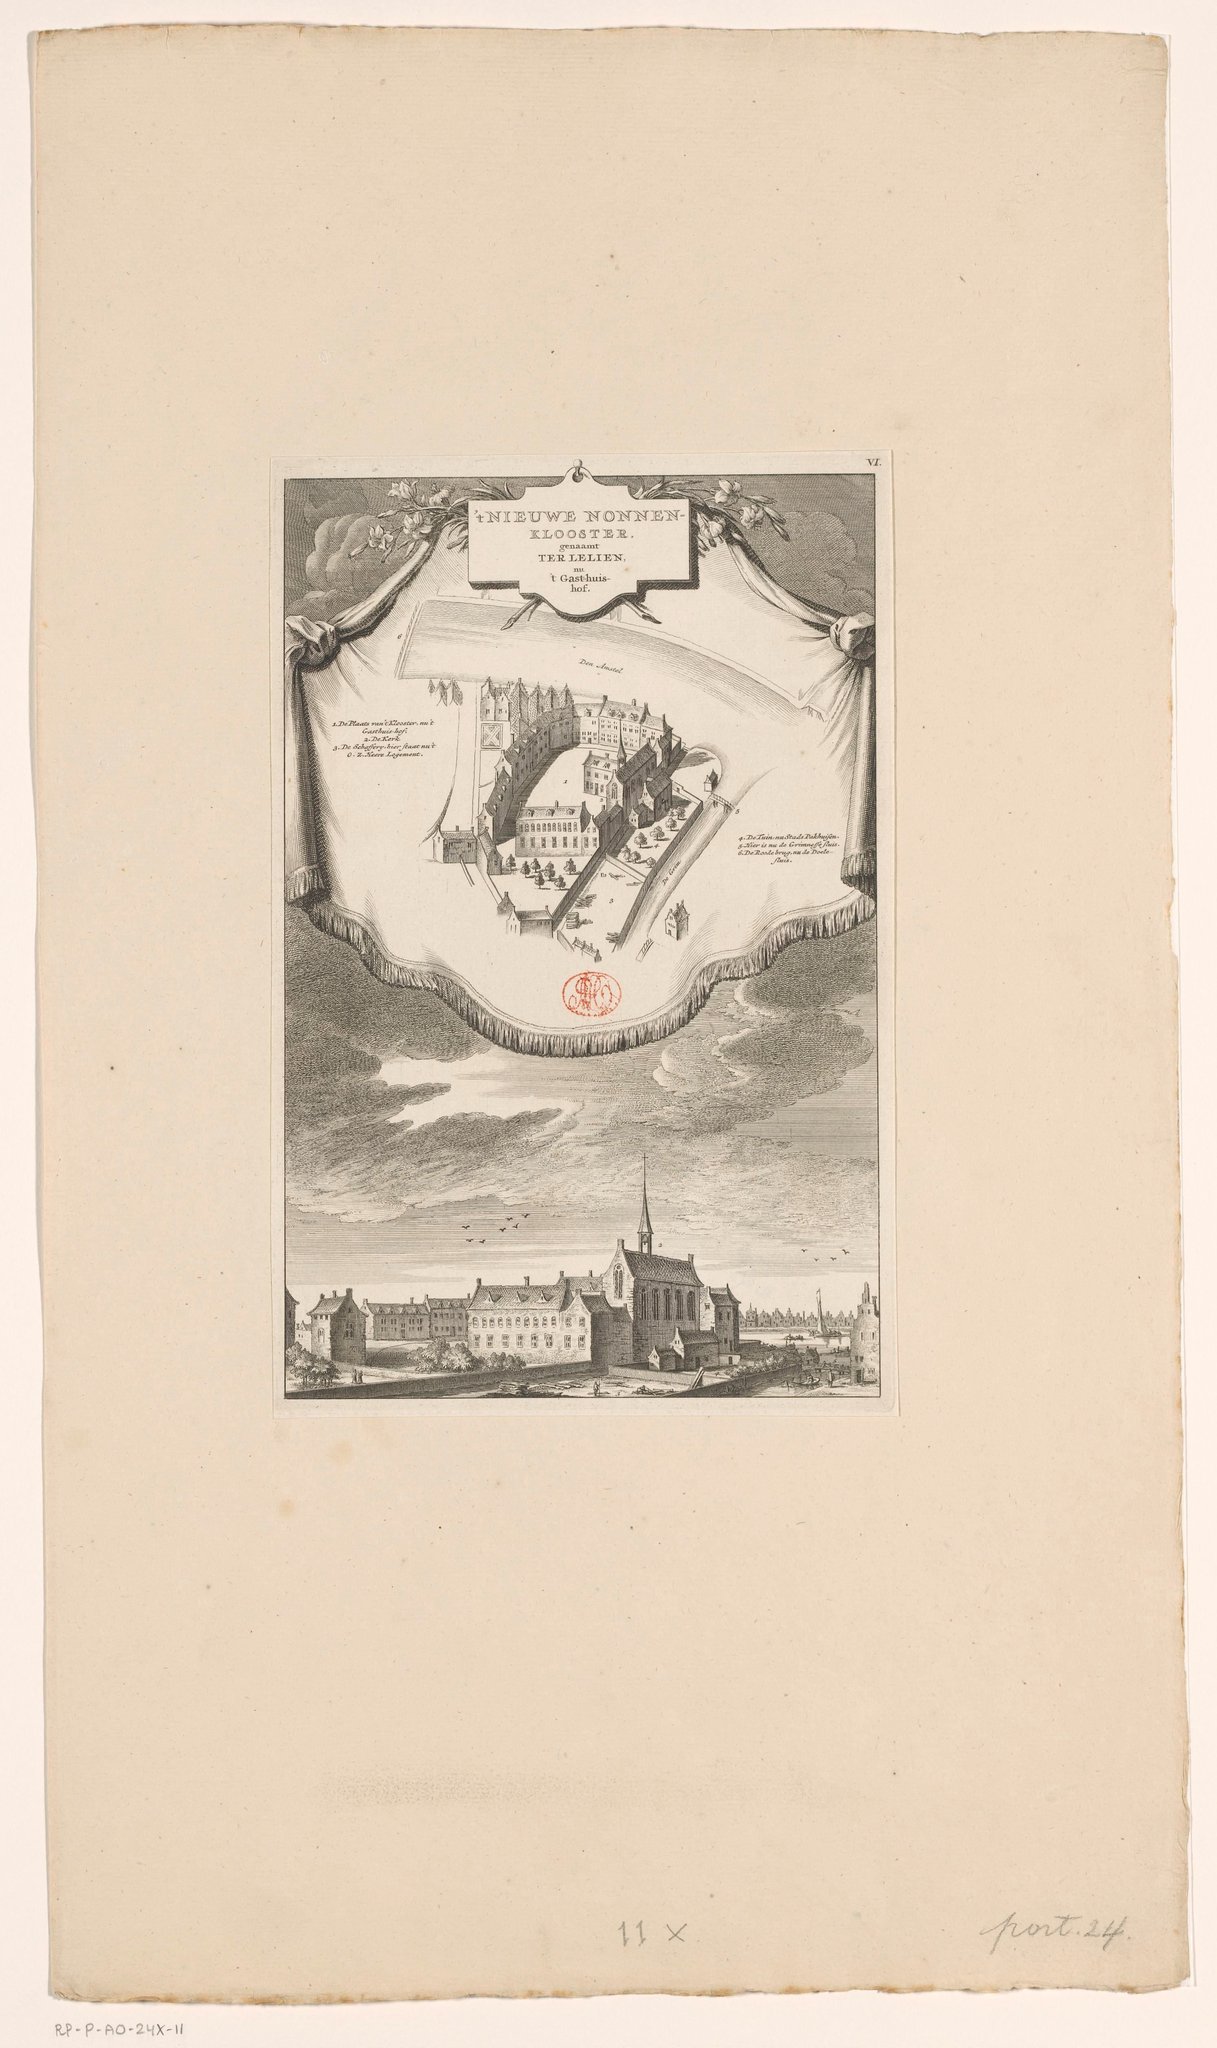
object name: print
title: Gezichten op het Nieuwe Nonnenklooster te Amsterdam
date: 1760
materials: paper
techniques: engraving, etching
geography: amsterdam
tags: abbey, monastery, convent ~ roman catholic church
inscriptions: collector's mark: Lugt 195, collector's mark: Lugt 2233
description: Prent ook gebruikt in: Wagenaar, Jan. Amsterdam, in zyne opkomst, aanwas, geschiedenissen (…). 3 delen [folio-uitgave]. Amsterdam: Isaak Tirion en Yntema & Tieboel, 1760-1767, dl. 1 (Isaac Tirion, 1760). Zie RP-P-AO-24X-12 voor proefdruk. Dat de prent de situatie rond 1544 weergeeft gaat terug op het feit dat voor het maken van deze en andere prenten van kloosters en kerken van voor de Alteratie (1578) is uitgegaan van de plattegrond van Cornelis Anthonisz. uit 1544 (zie RP-P-OB-70.399 en RP-P-AO-20-15).